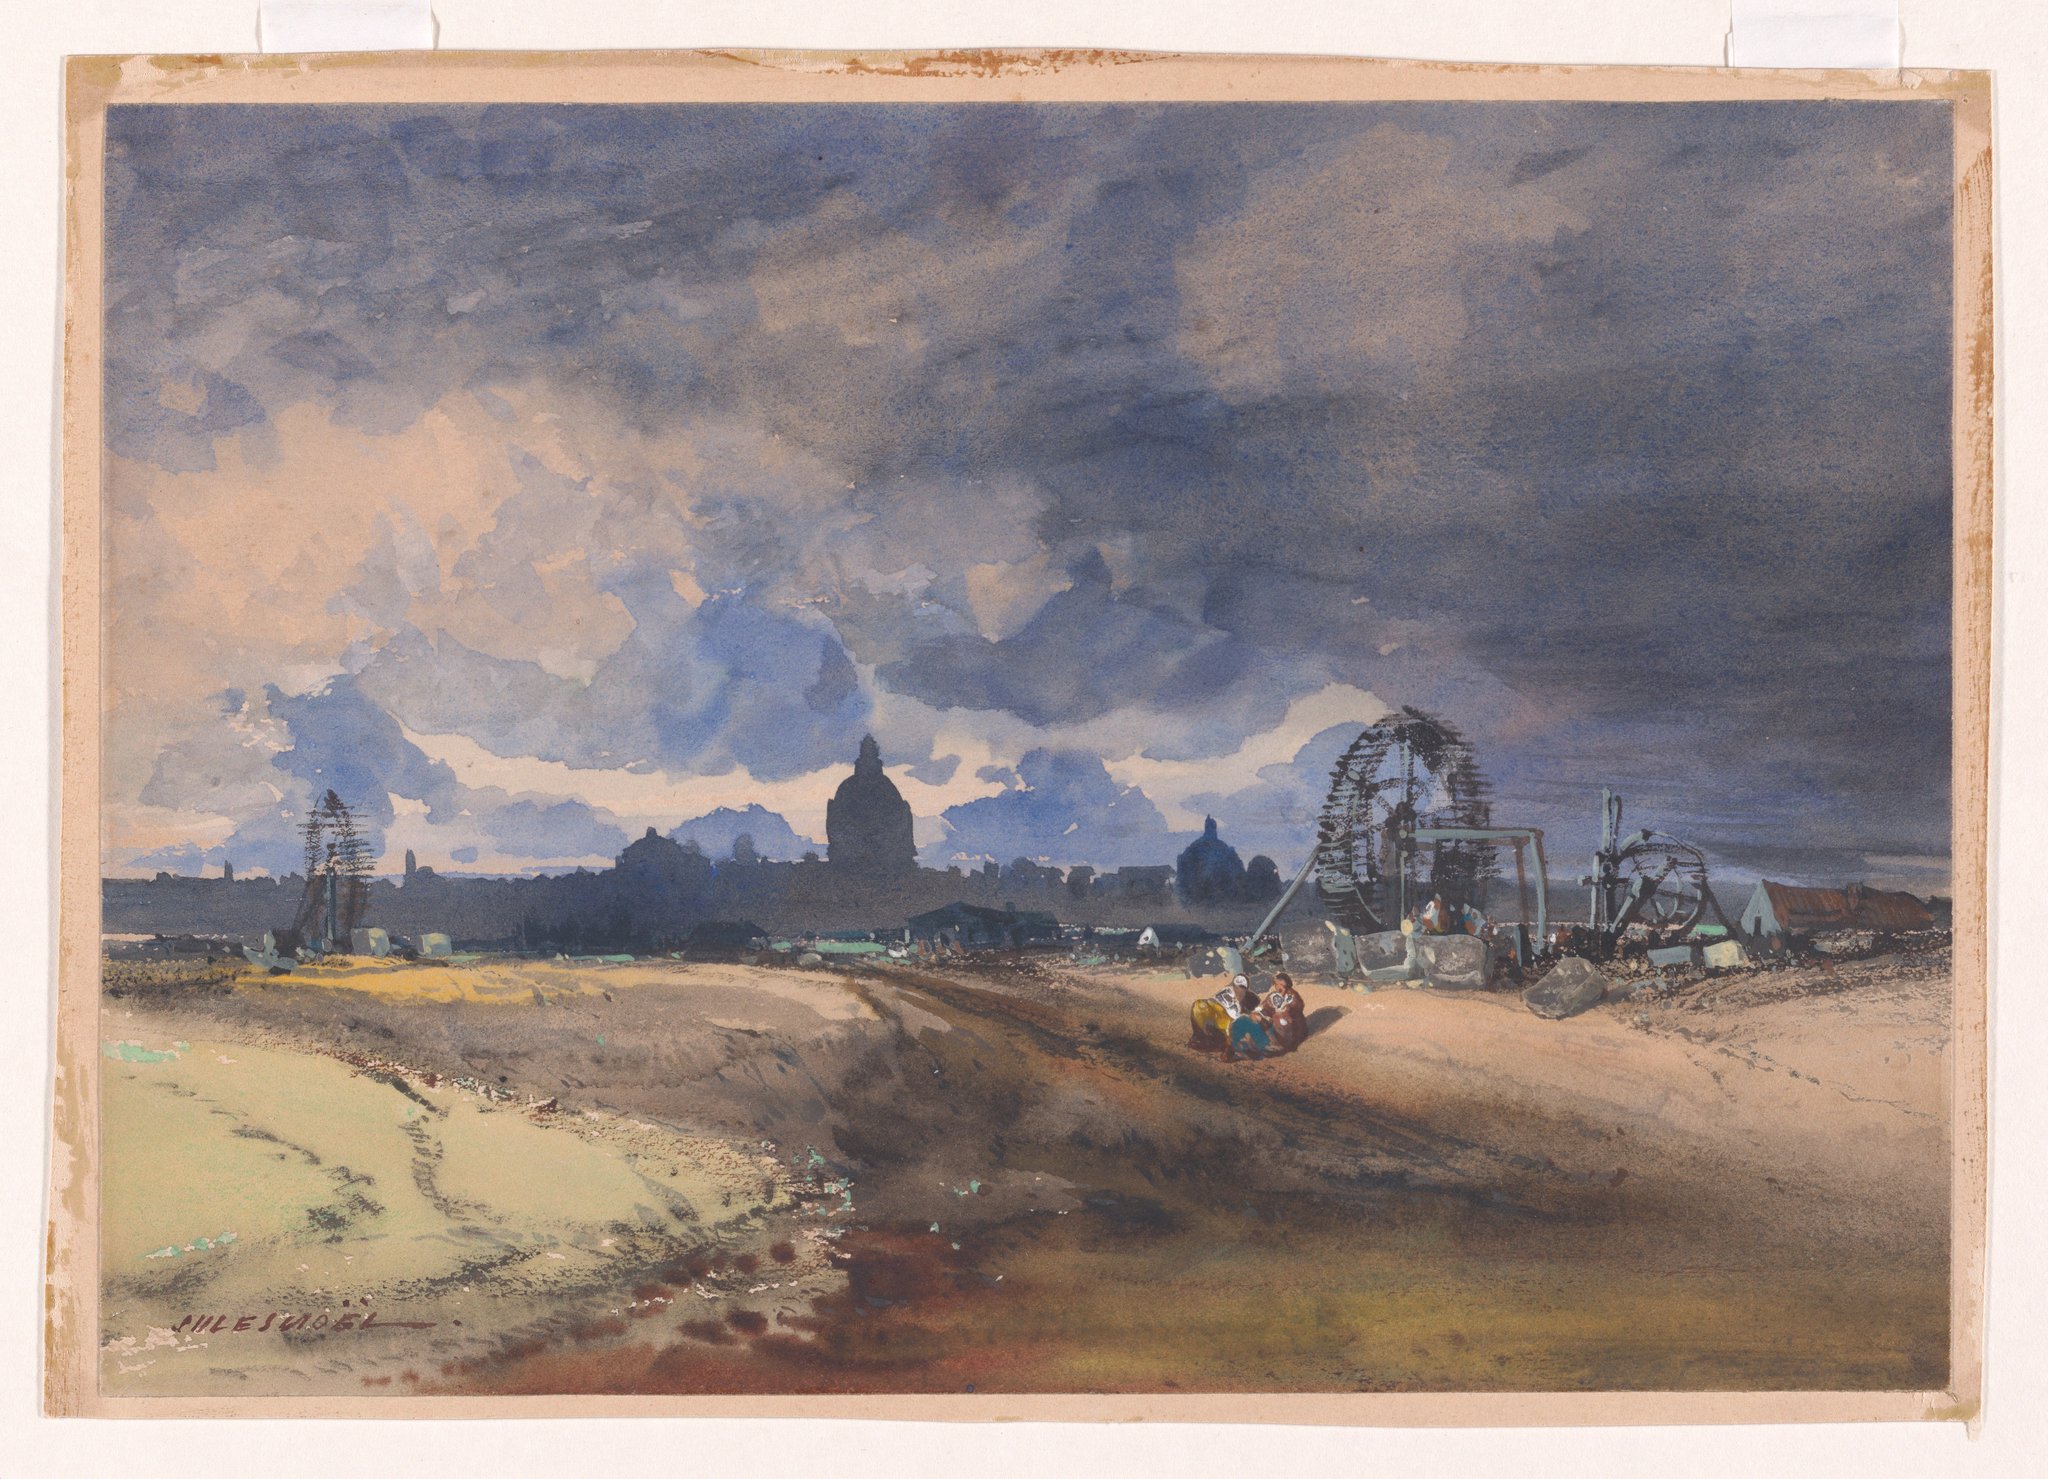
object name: drawing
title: A View of Paris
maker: jules-achille noël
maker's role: artist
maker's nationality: french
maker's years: 1815-1881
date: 1830-1881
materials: gouache, ink, lead, watercolor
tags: landscapes,paris